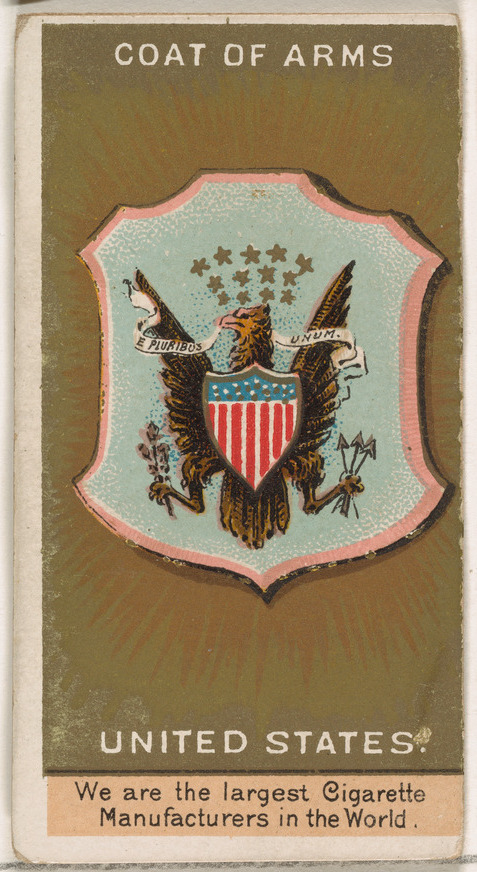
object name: print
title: President Cleveland, United States, from the Rulers, Flags, and Coats of Arms series (N126-2) issued by W. Duke, Sons & Co.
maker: w. duke, sons & co.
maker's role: publisher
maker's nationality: american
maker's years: 1870-1920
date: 1888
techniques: color lithograph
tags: coat of arms